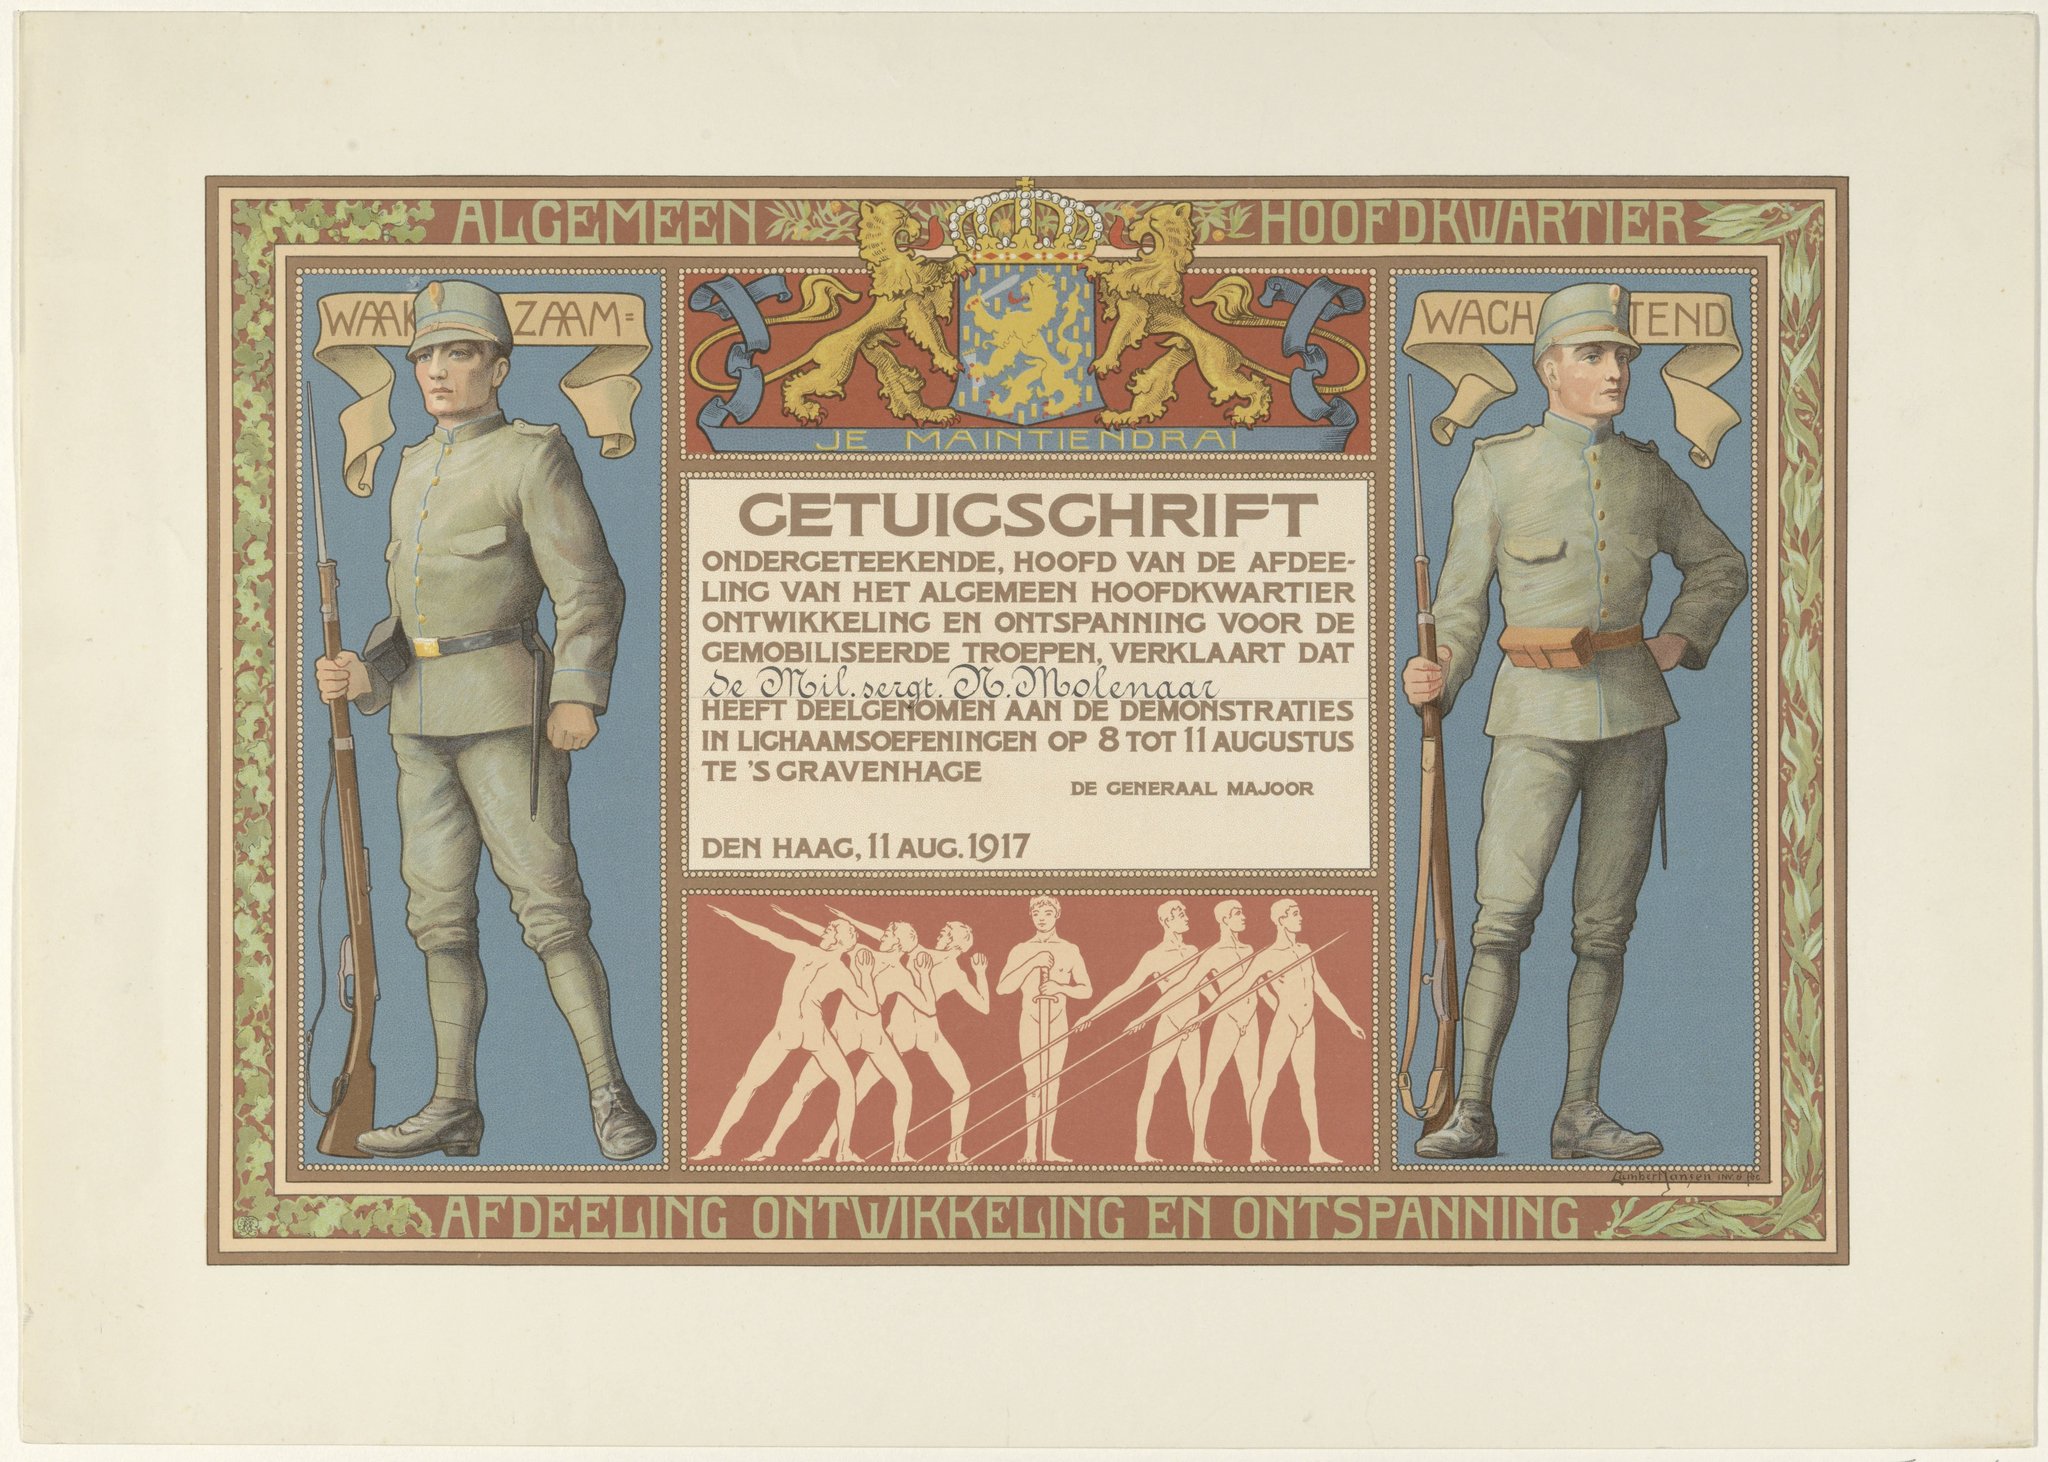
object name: testimonial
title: Getuigschrift van deelname door sergeant N. Molenaar aan de demonstraties en lichaamsoefeningen, 8-11 augustus 1917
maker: lambert jansen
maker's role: draughtsman, print maker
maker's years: 1891-1965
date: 1917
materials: paper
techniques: chromolithography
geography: netherlands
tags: military honours, the hague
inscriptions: collector's mark: Lugt 2228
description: Getuigschrift afgeven door de 'Afdeeling Ontwikkeling en Ontspanning' van het 'Algemeen Hoofdkwartier' van de deelname door sergeant N. Molenaar aan de demonstraties en lichaamsoefeningen voor de gemobiliseerde troepen tussen 8 en 11 augustus 1917, te Den Haag. Centraal de tekst, aan weerszijden staande militairen in uniform met de opschriften 'waakzaam' en 'wachtend'.